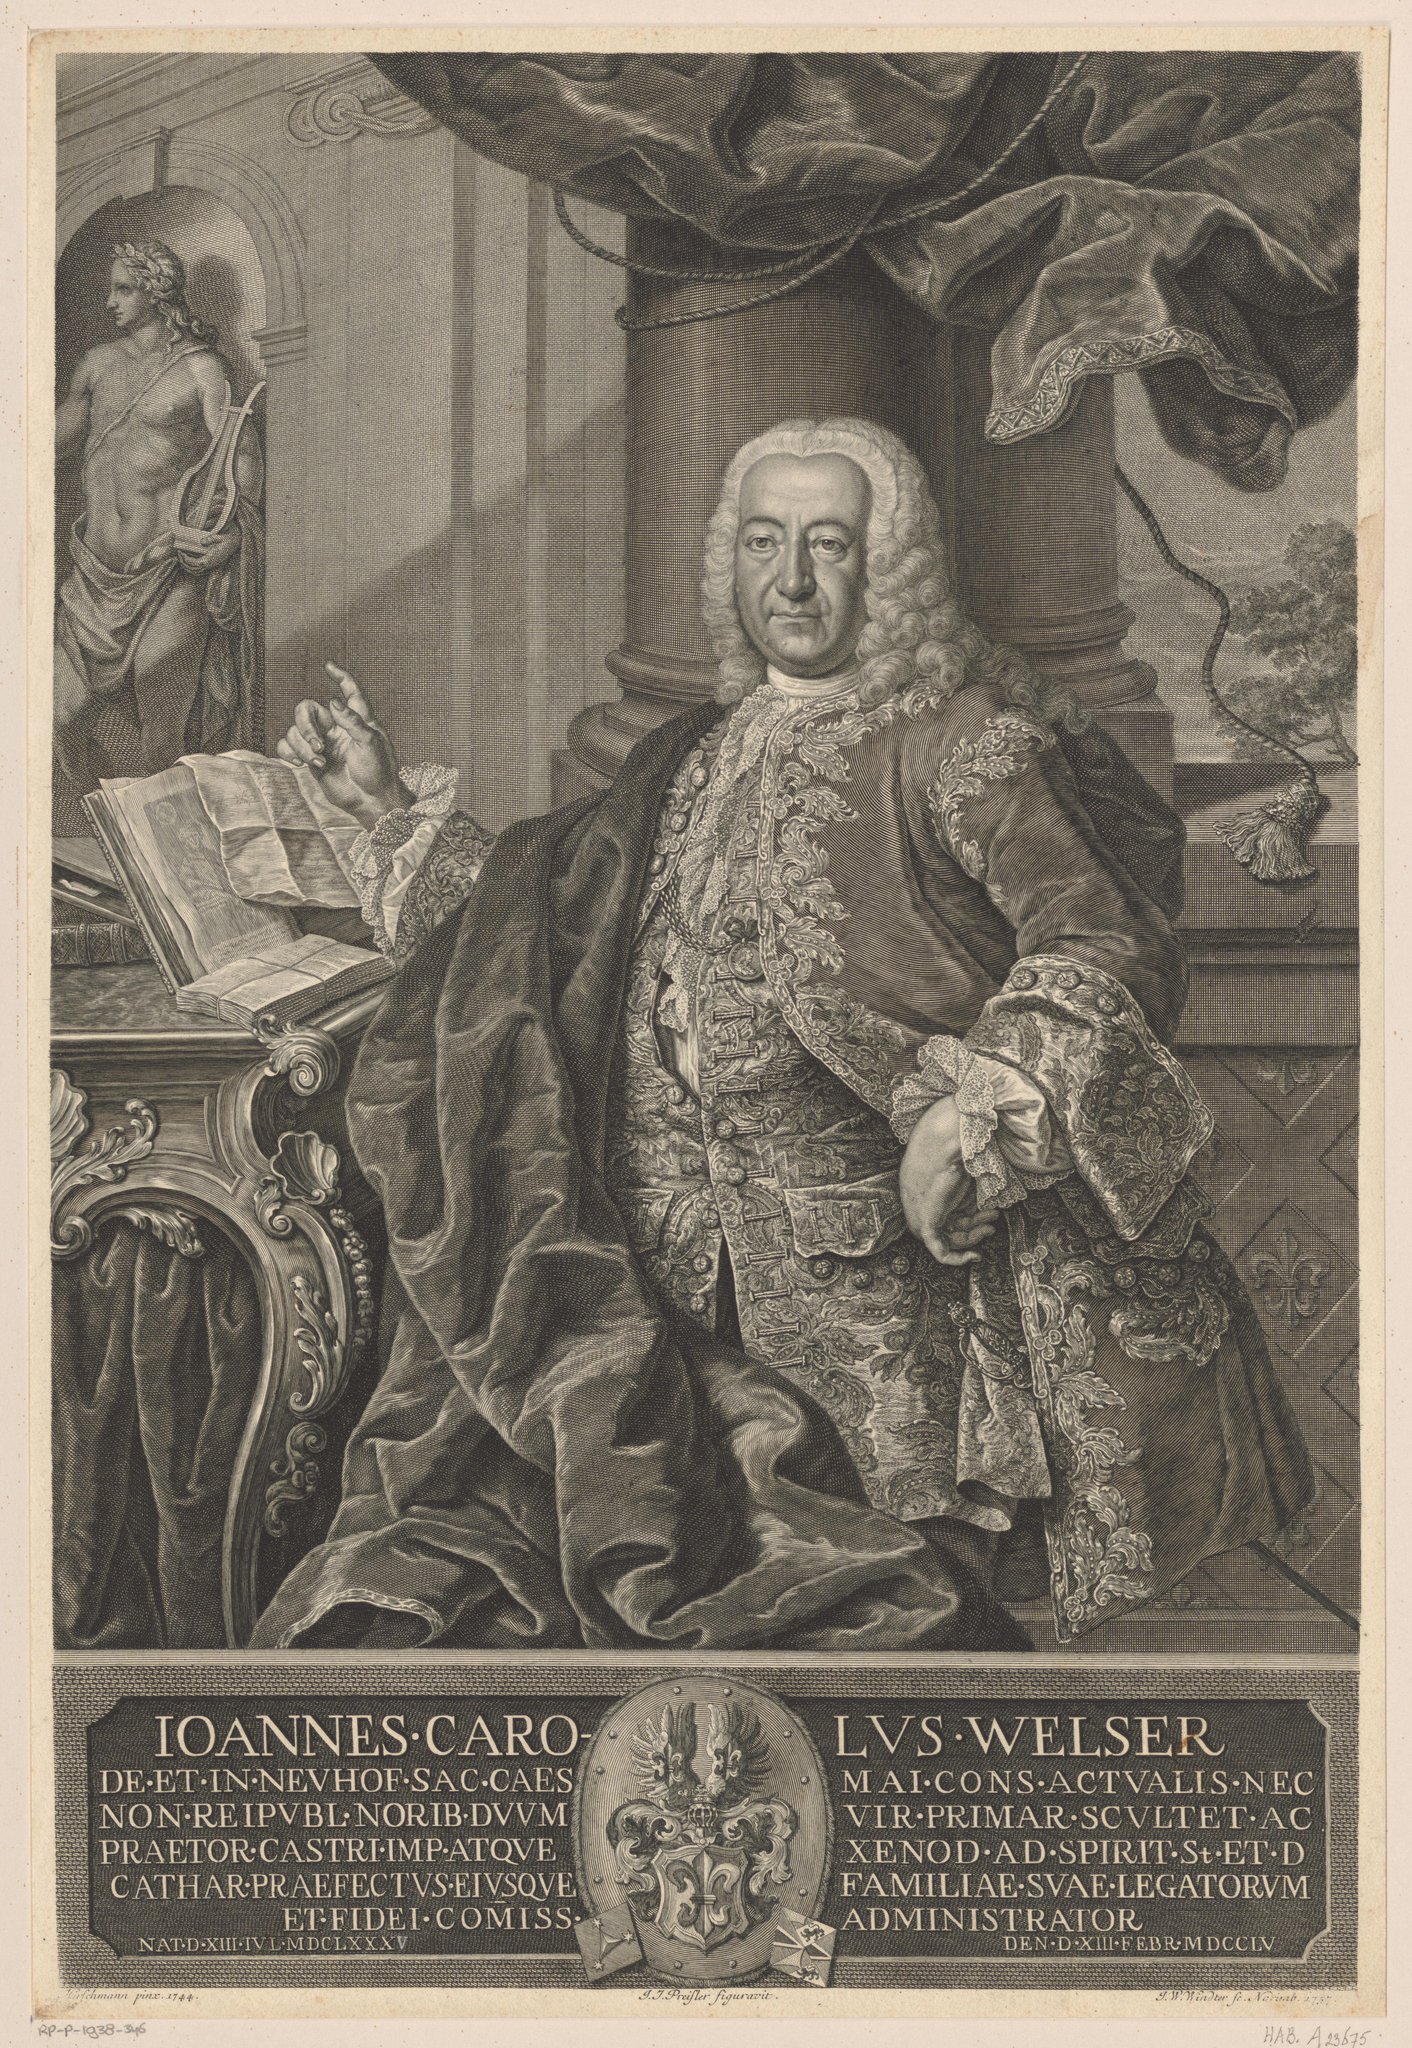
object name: print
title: Portret van Johann Karl Welser von Neunhof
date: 1757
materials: paper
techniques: engraving, etching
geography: nuremberg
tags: mayor, historical persons, book, armorial bearing, heraldry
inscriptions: collector's mark: Lugt 2228